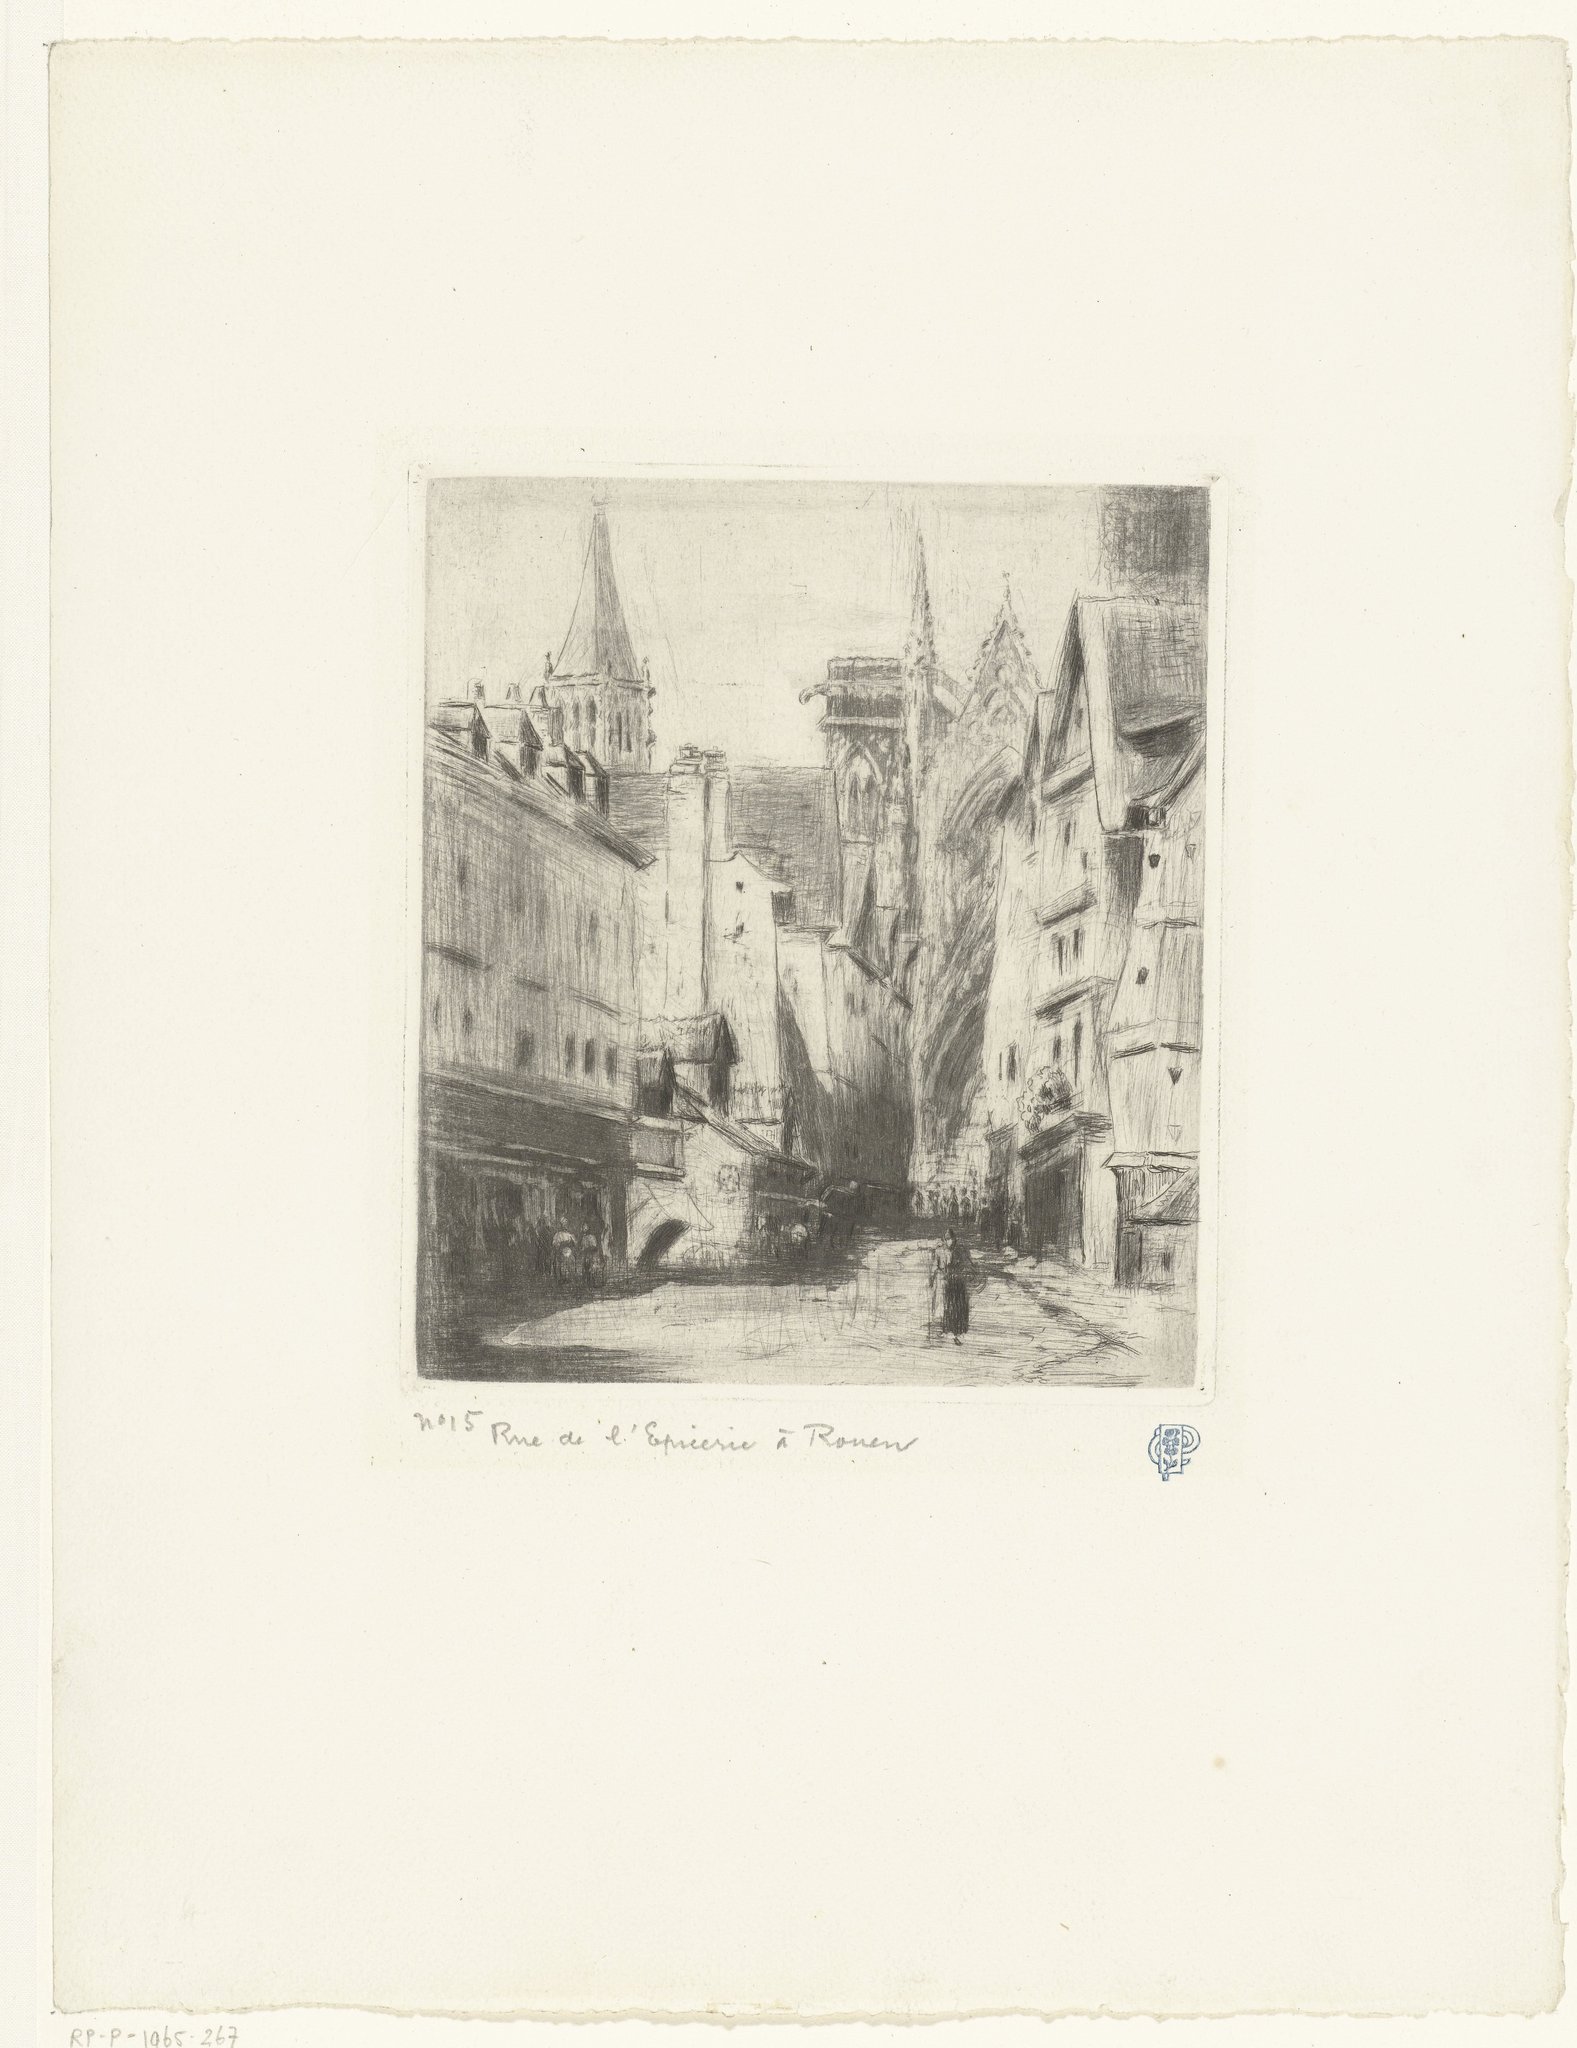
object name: print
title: Rue de L'Epicerie in Rouen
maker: camille jacob pissarro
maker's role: draughtsman, print maker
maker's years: 1830-1903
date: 1886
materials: paper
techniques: drypoint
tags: church (exterior), street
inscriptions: stamp: Lugt 613d, inscription: ‘No 15’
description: Deze prent is in 1907 uitgegeven als onderdeel van een serie van tien prenten van Camille Pissarro. Zie Delteil 1999, p. xvii. K.Botke